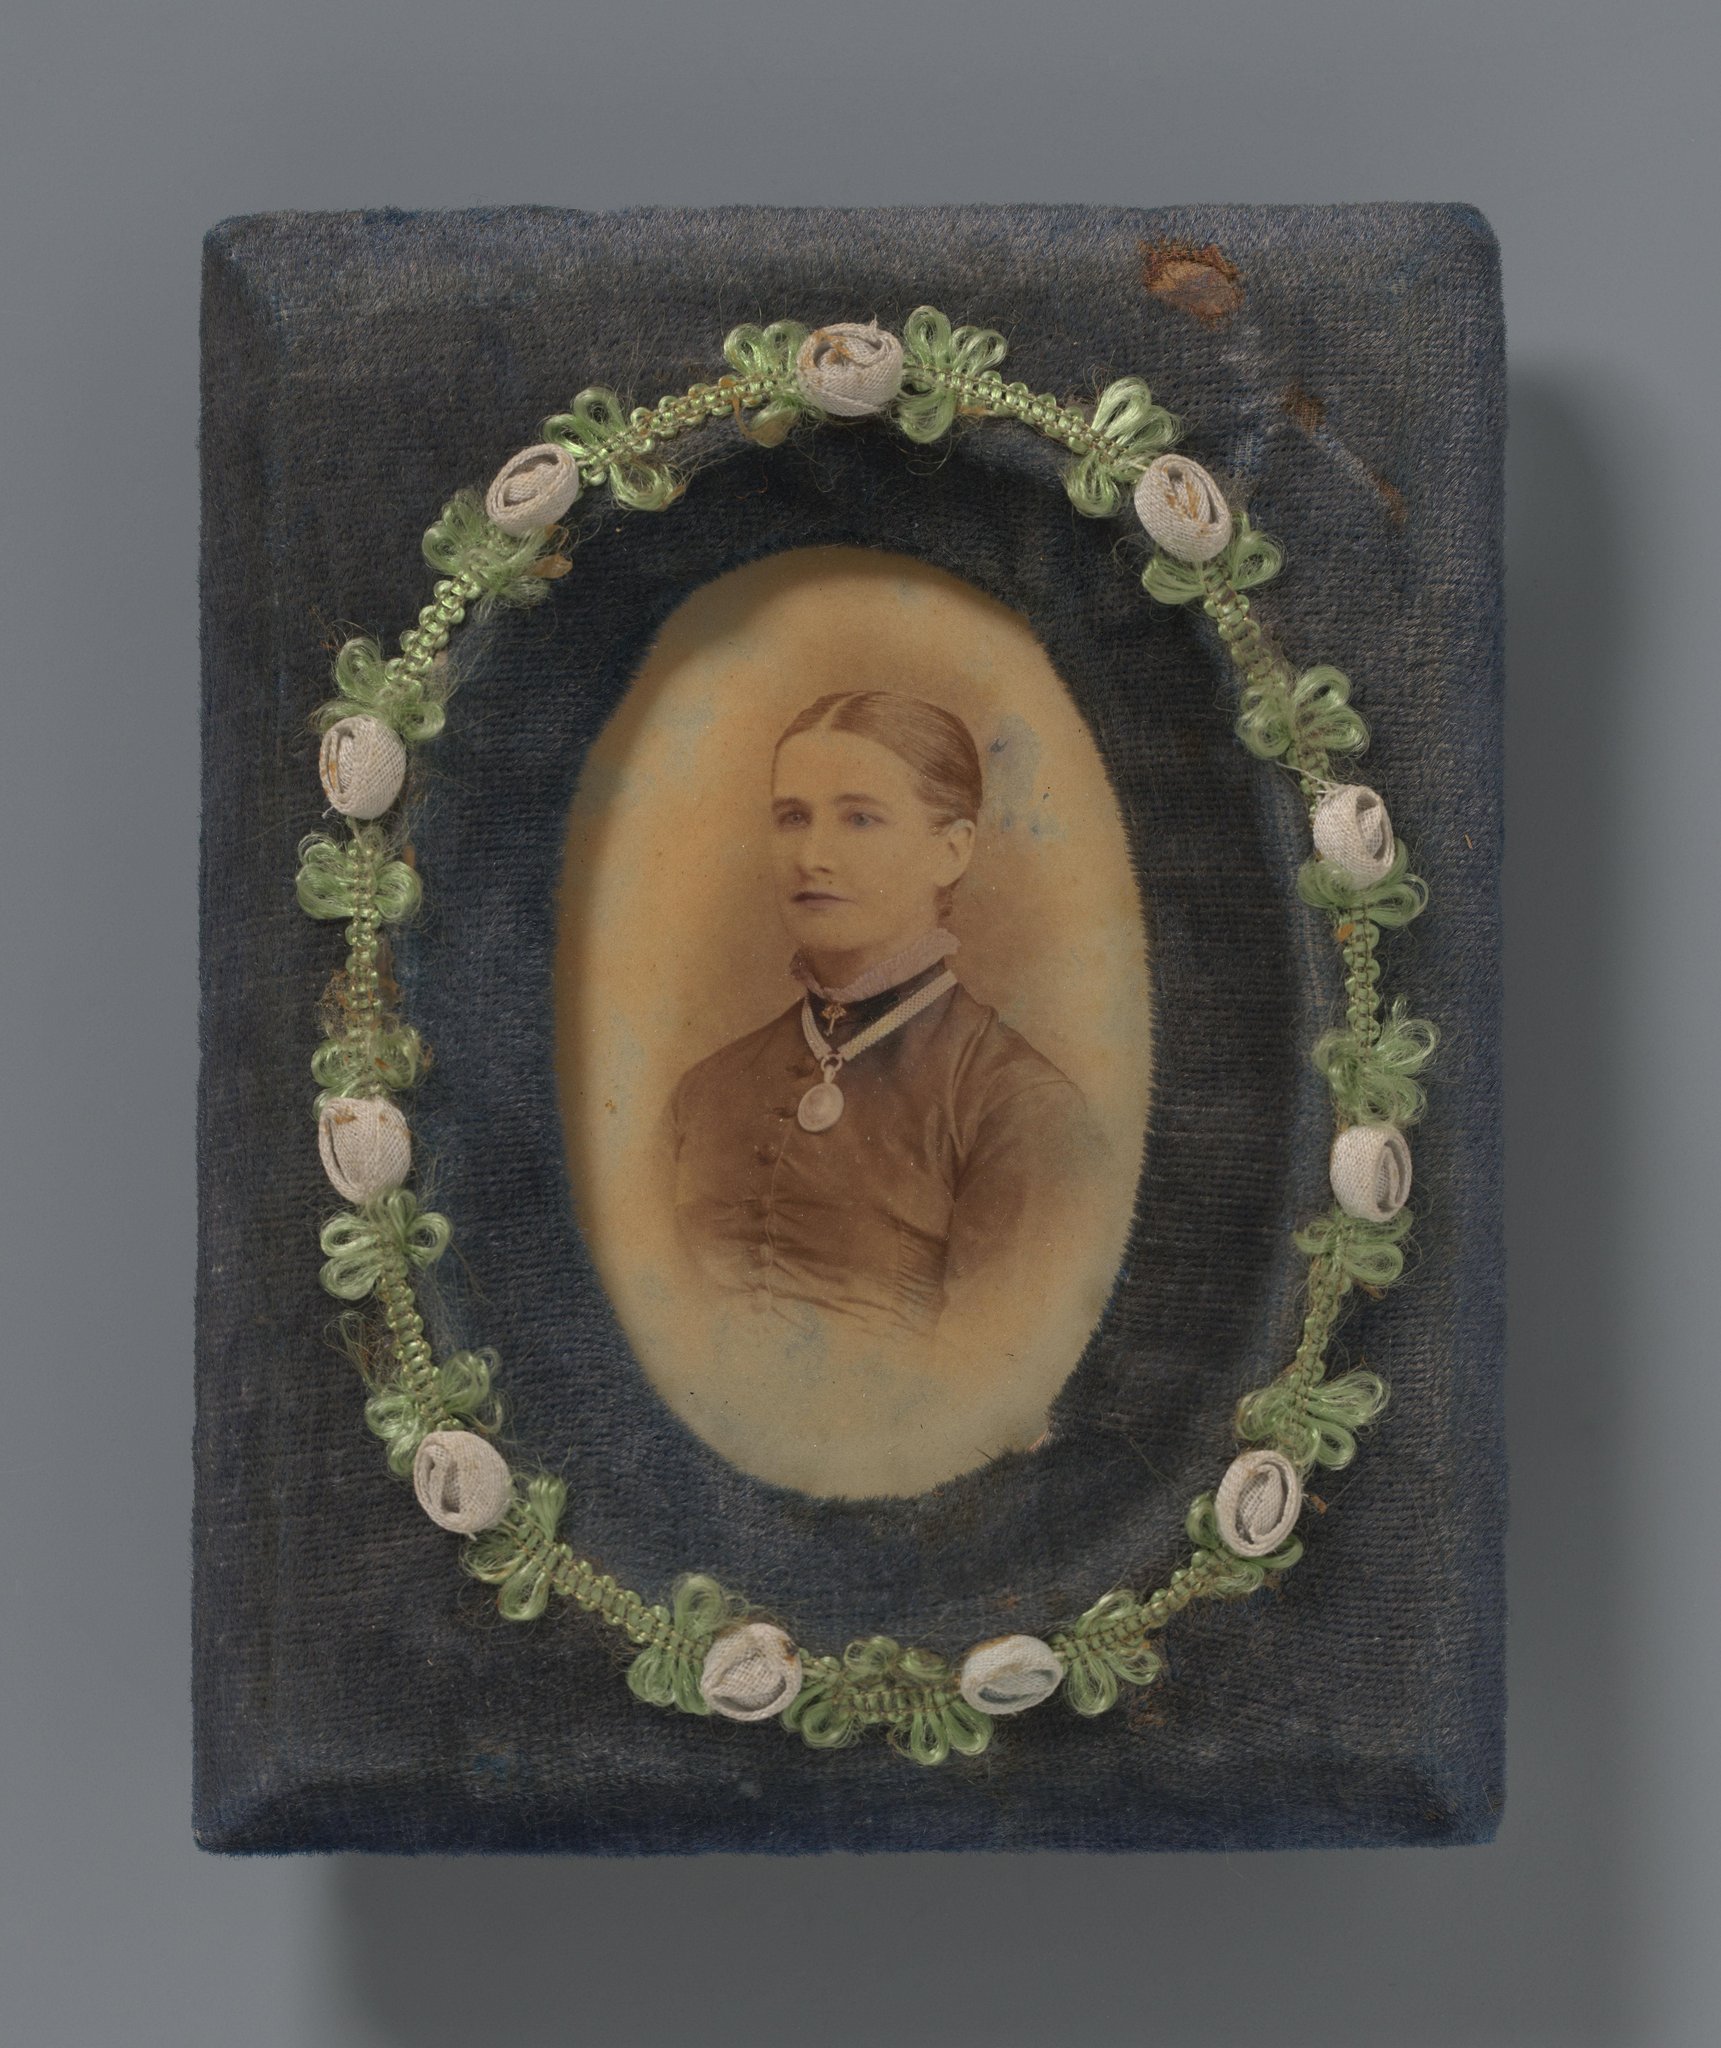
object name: frame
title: Portret van een onbekende vrouw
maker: Anonymous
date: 1860-1900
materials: cardboard, metal, velvet, yarns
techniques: embroidered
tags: historical persons not known by name - bb - woman